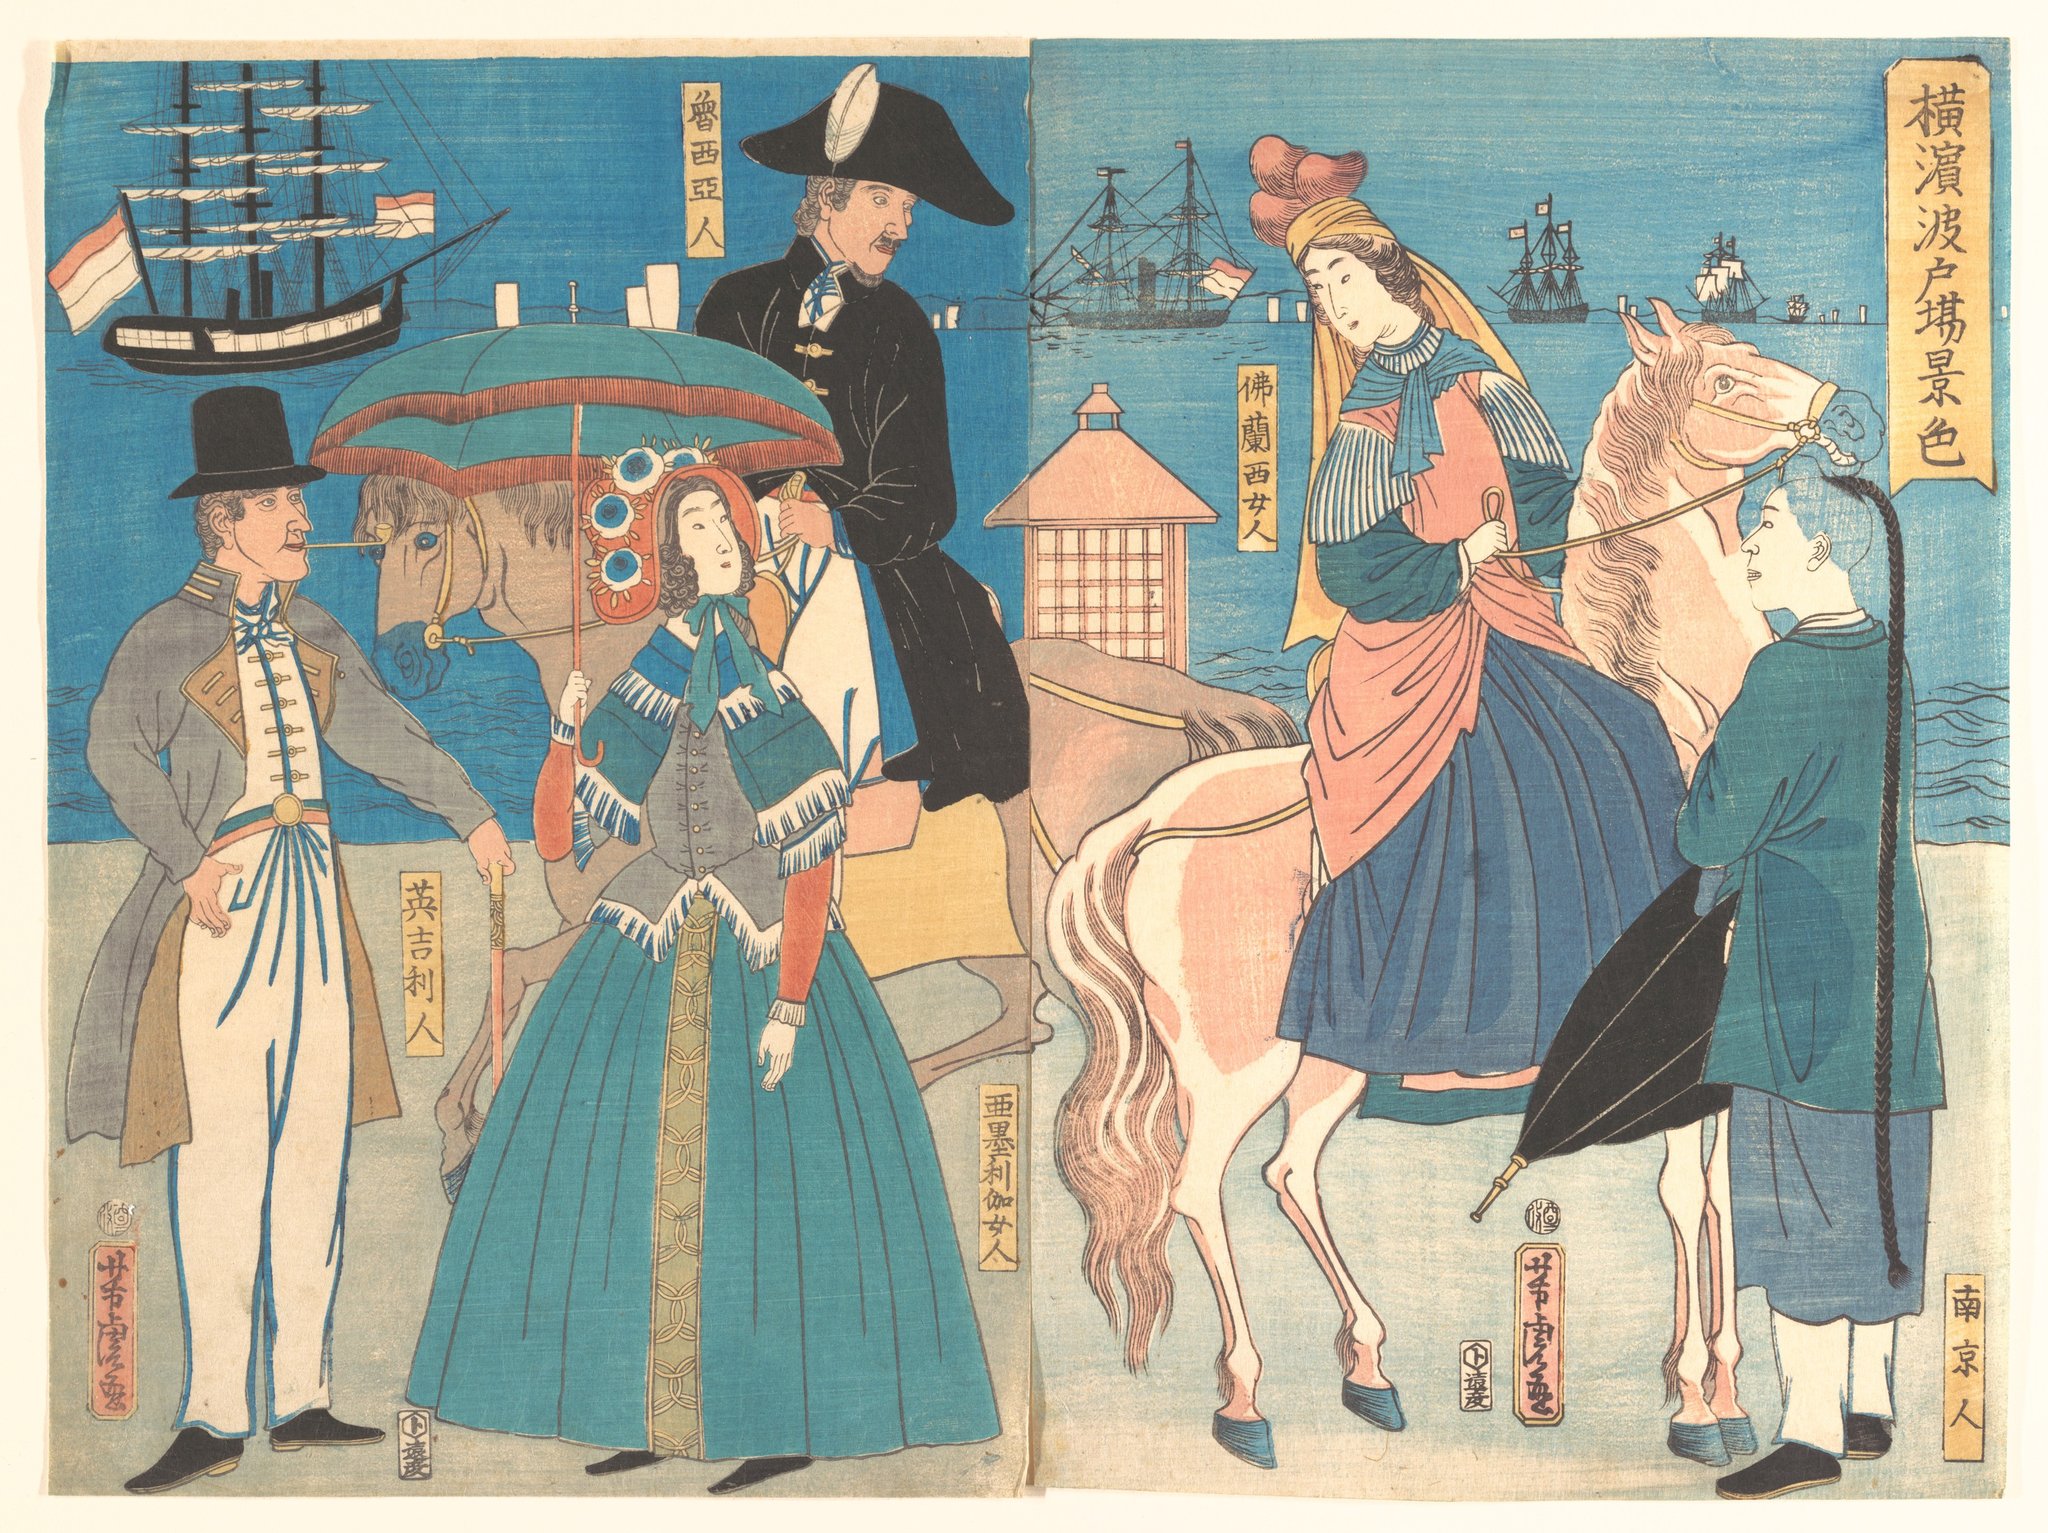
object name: print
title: A View of the Wharves in Yokohama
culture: japanese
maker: utagawa yoshitora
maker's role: artist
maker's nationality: japanese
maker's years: 1845-1880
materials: ink, paper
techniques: woodblock print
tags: men,women,horses,ships